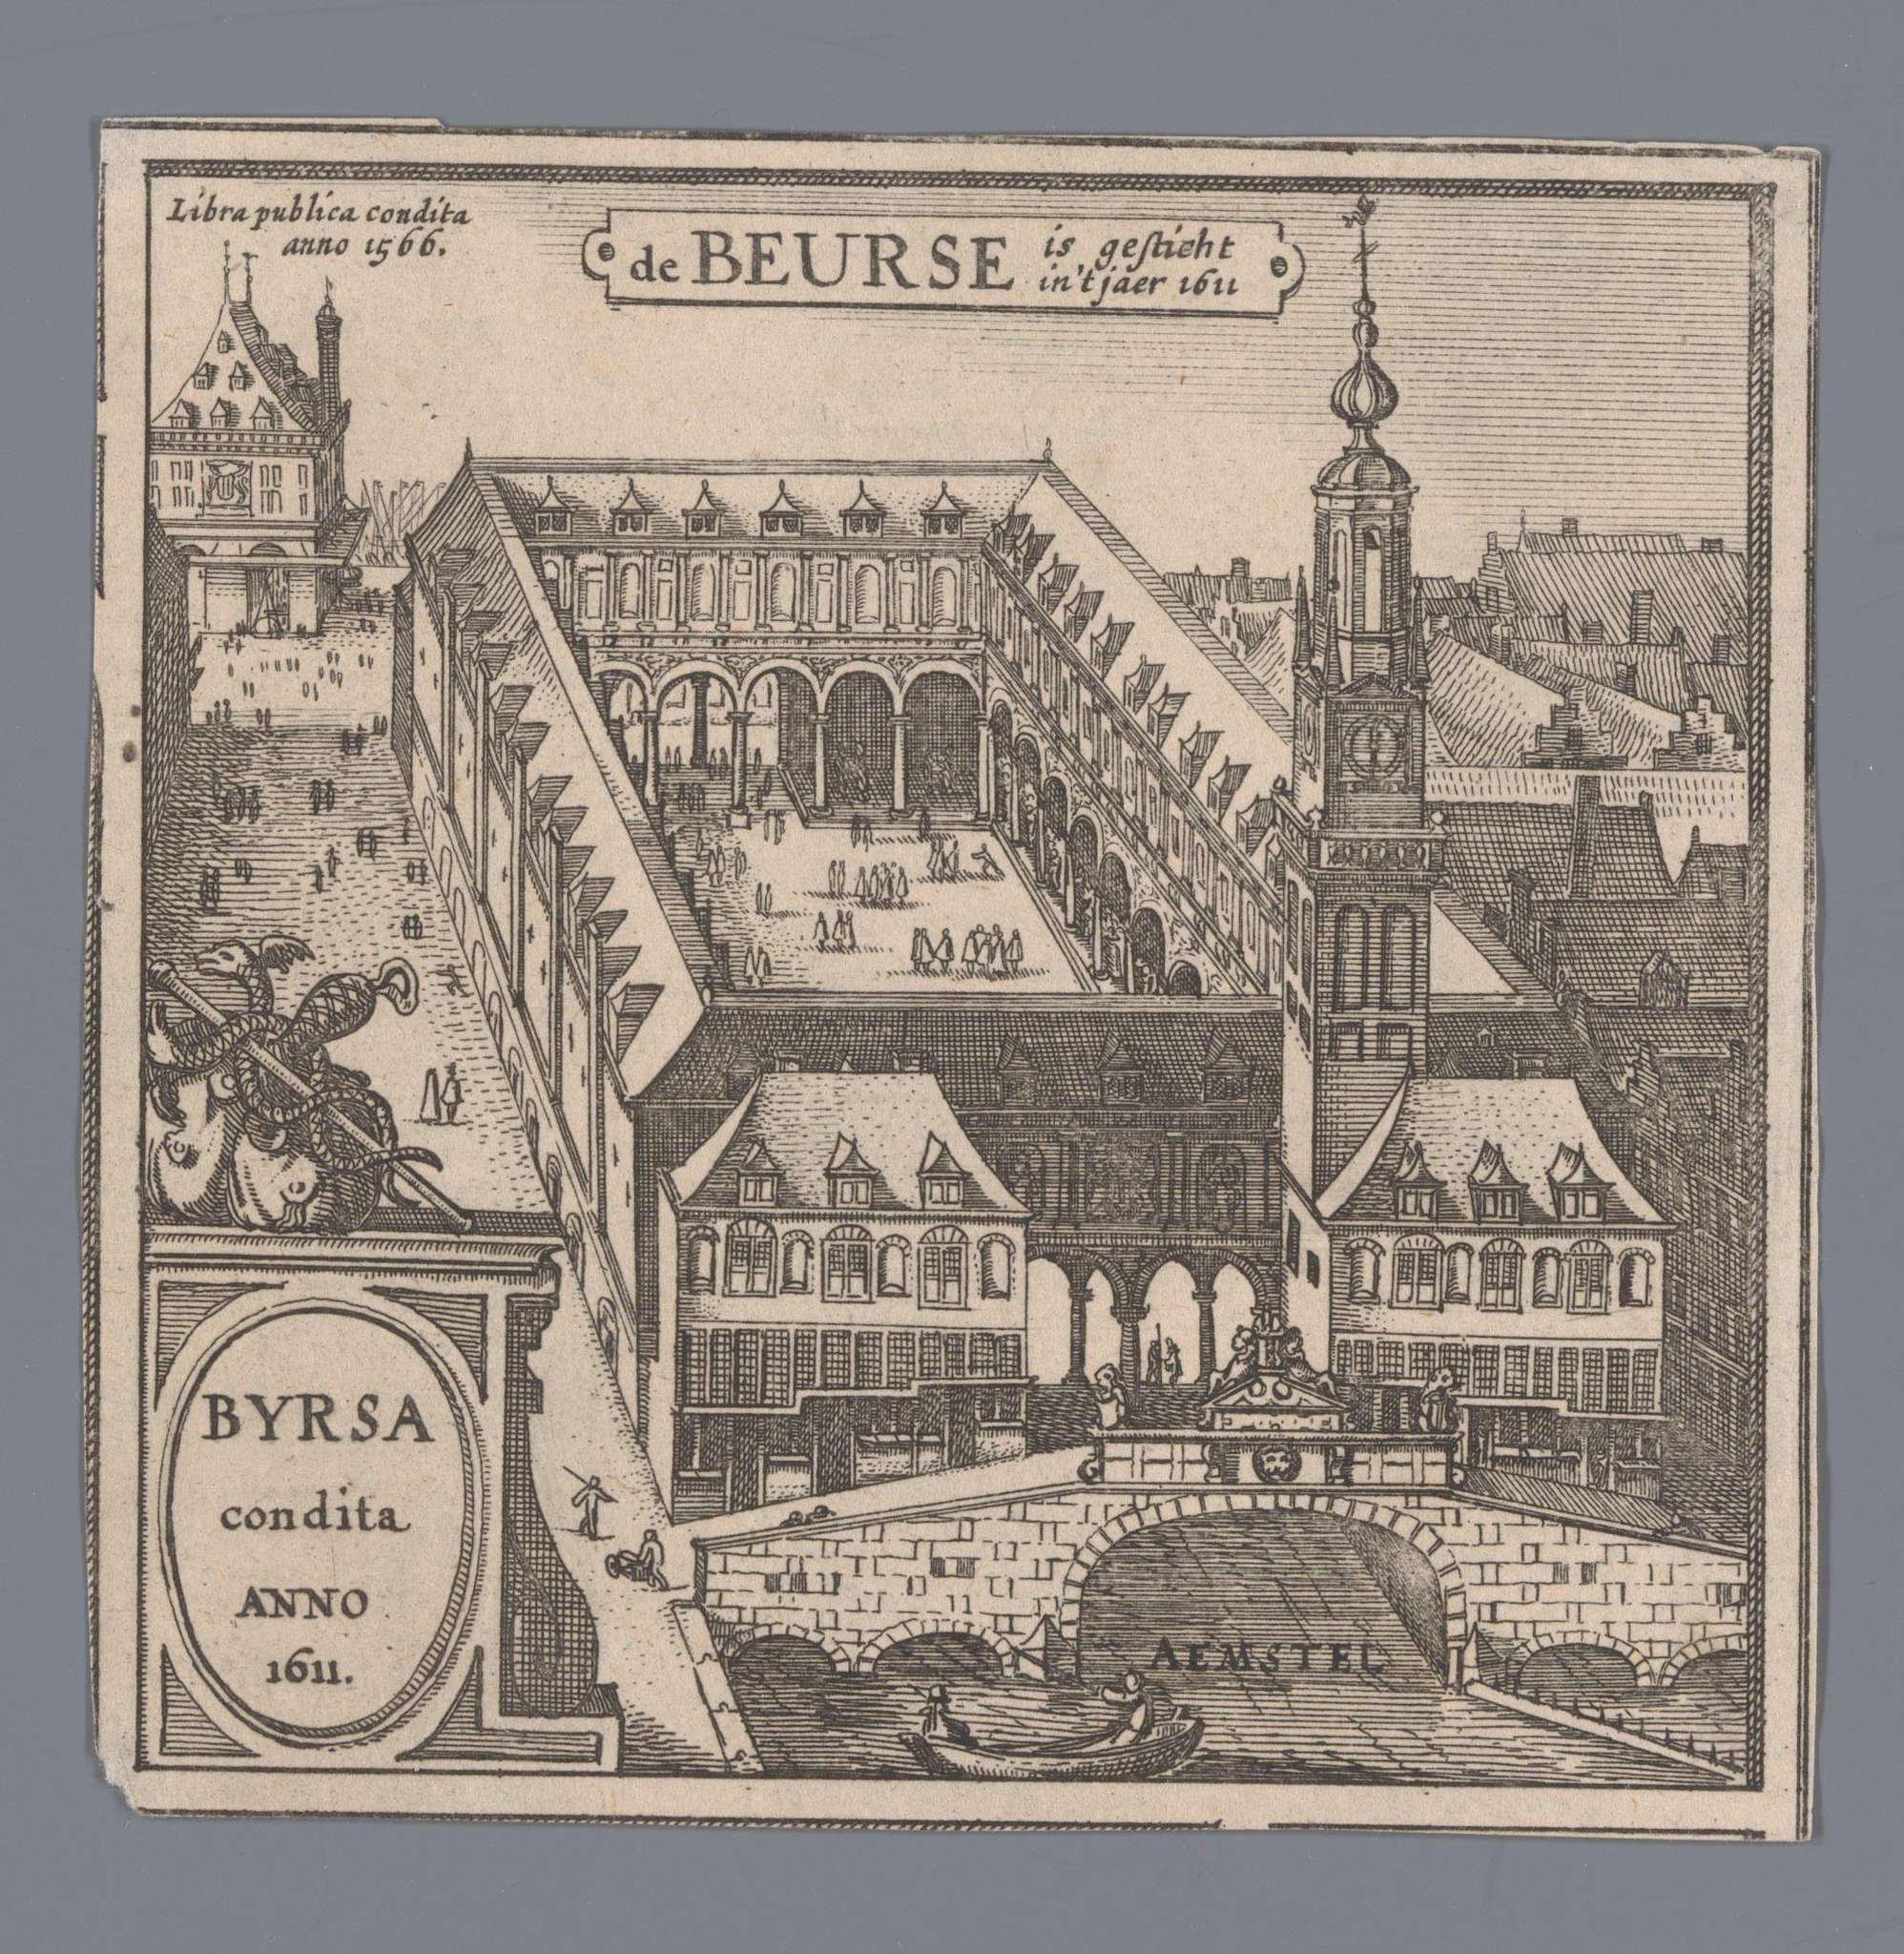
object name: print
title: De Beurse is gesticht in 't jaer 1611 / Byrse condita anno 1611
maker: Anonymous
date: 1611-1750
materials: paper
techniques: etching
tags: tower, clock tower ~ monumental adornment, stock exchange, stock-market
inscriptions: collector's mark: Lugt 2228